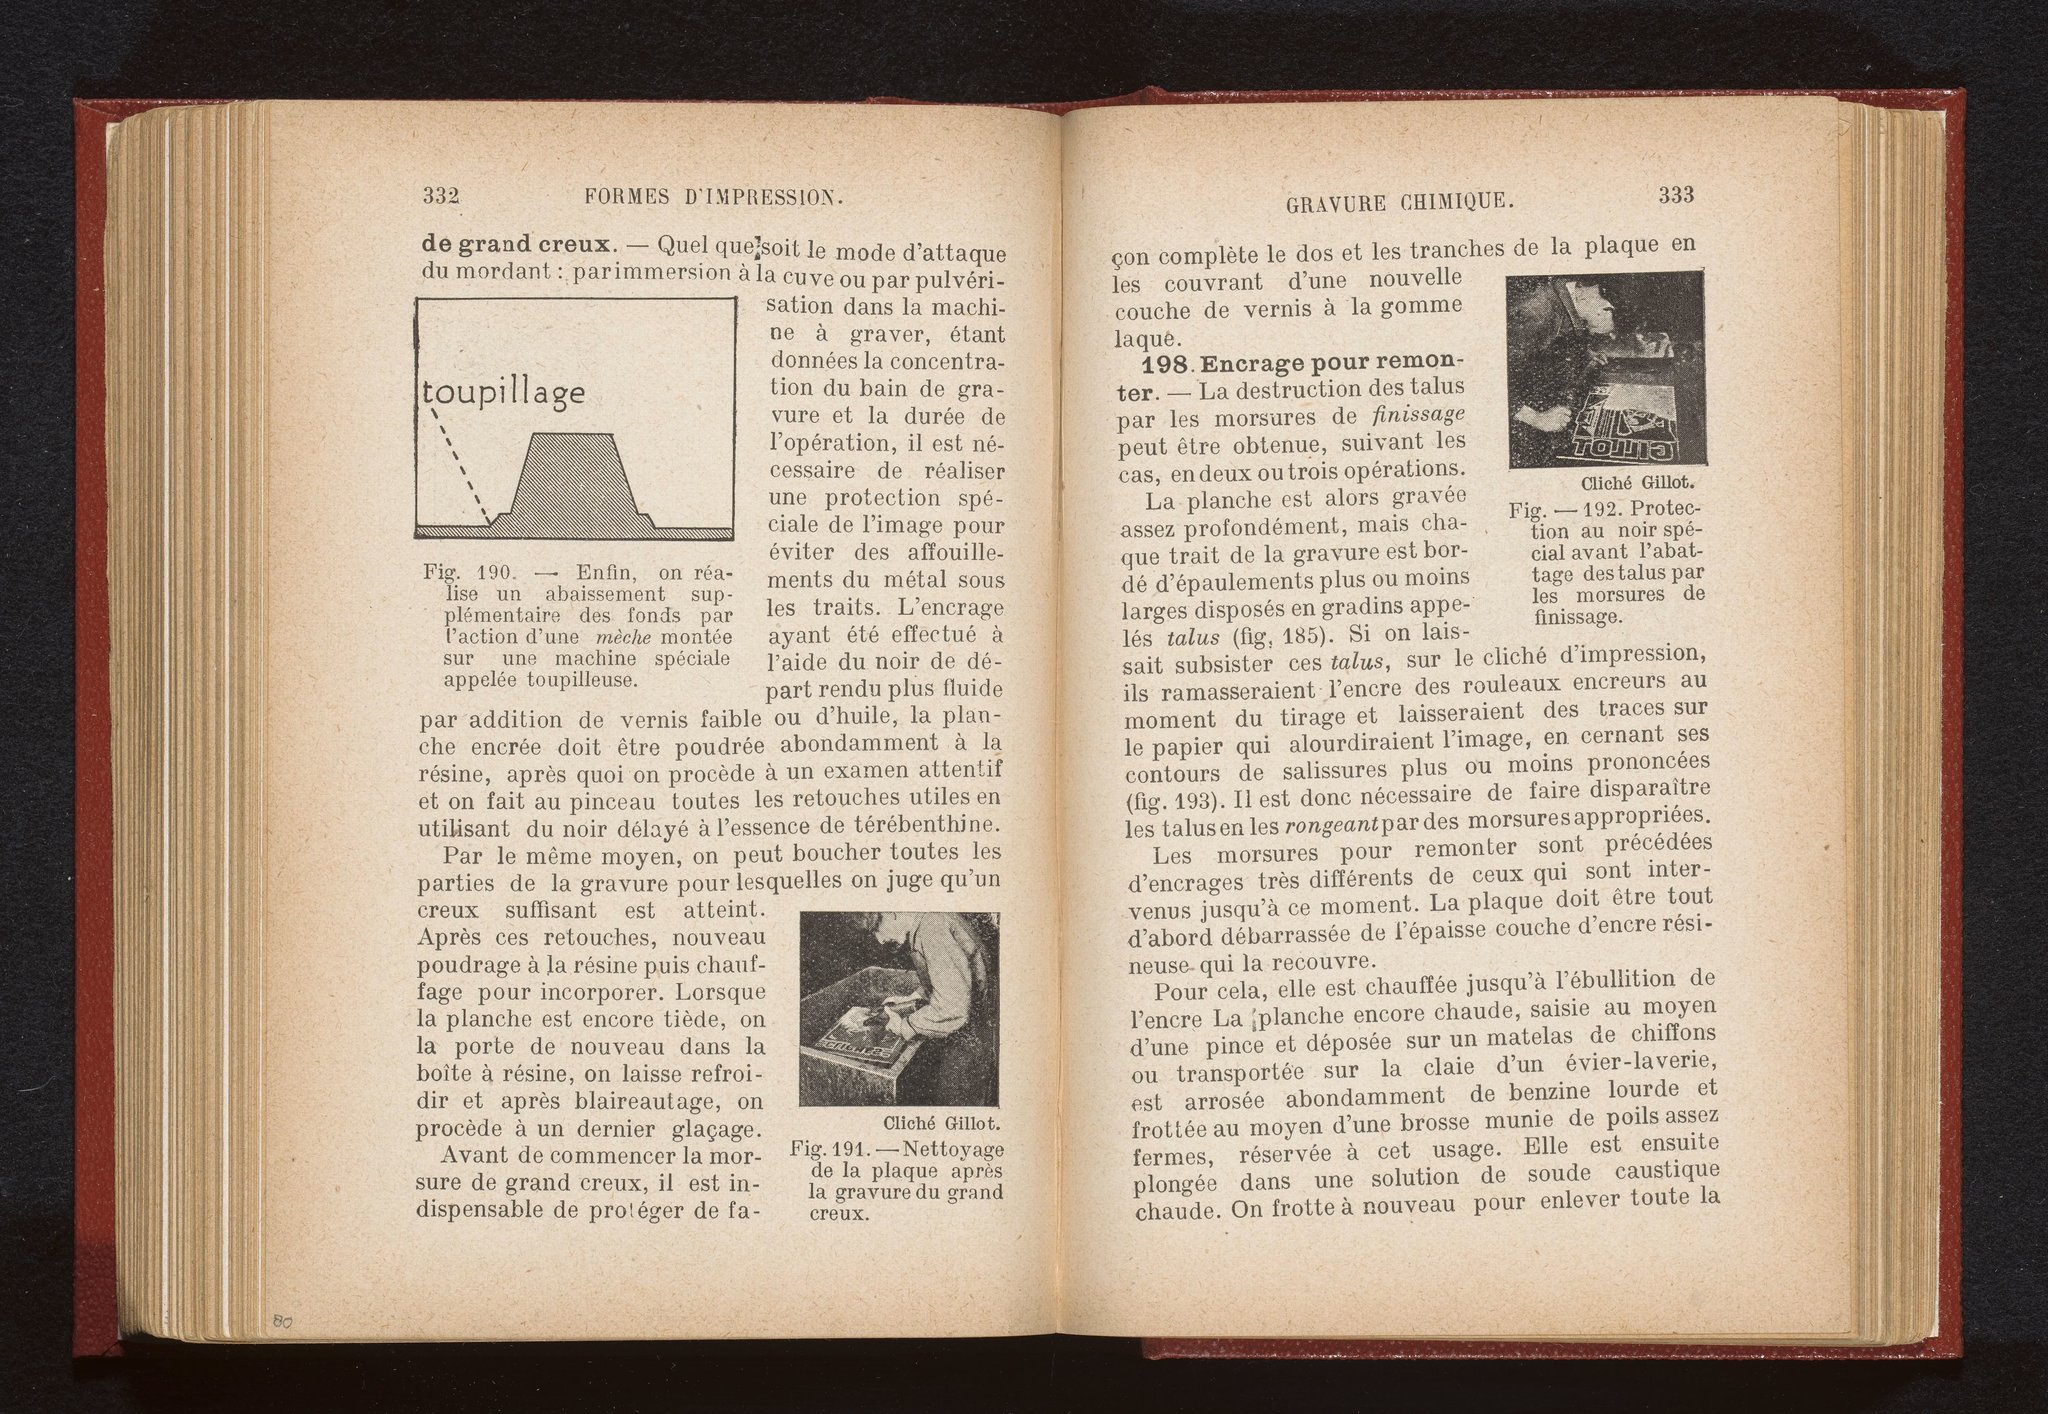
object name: photomechanical print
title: Protection au noir spécial avant l'abattage des talus par les morsures de finissage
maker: Anonymous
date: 1922-1932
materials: paper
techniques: autotype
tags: print, e.g.: engraving, etching, lithograph, photographic apparatus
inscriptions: number: ‘Fig. 192.’